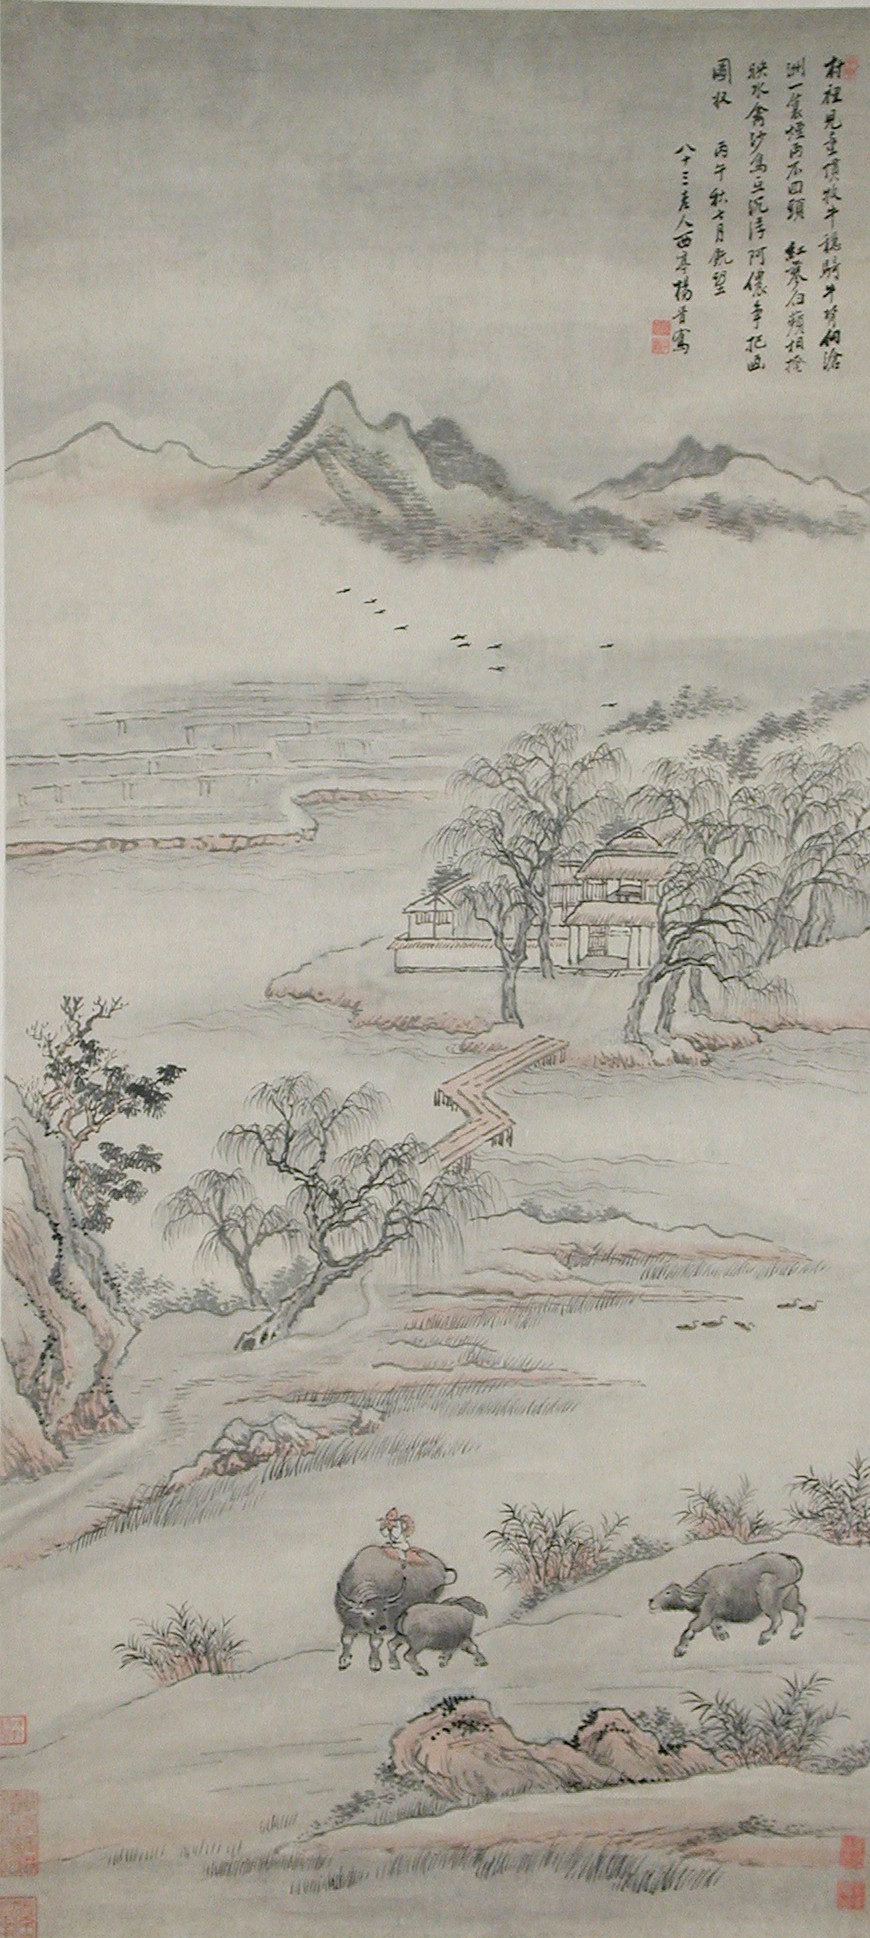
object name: hanging scroll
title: Landscape with Figures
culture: chinese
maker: yang jin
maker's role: artist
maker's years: 1644-1728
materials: ink, paper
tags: animals,mountains,landscapes